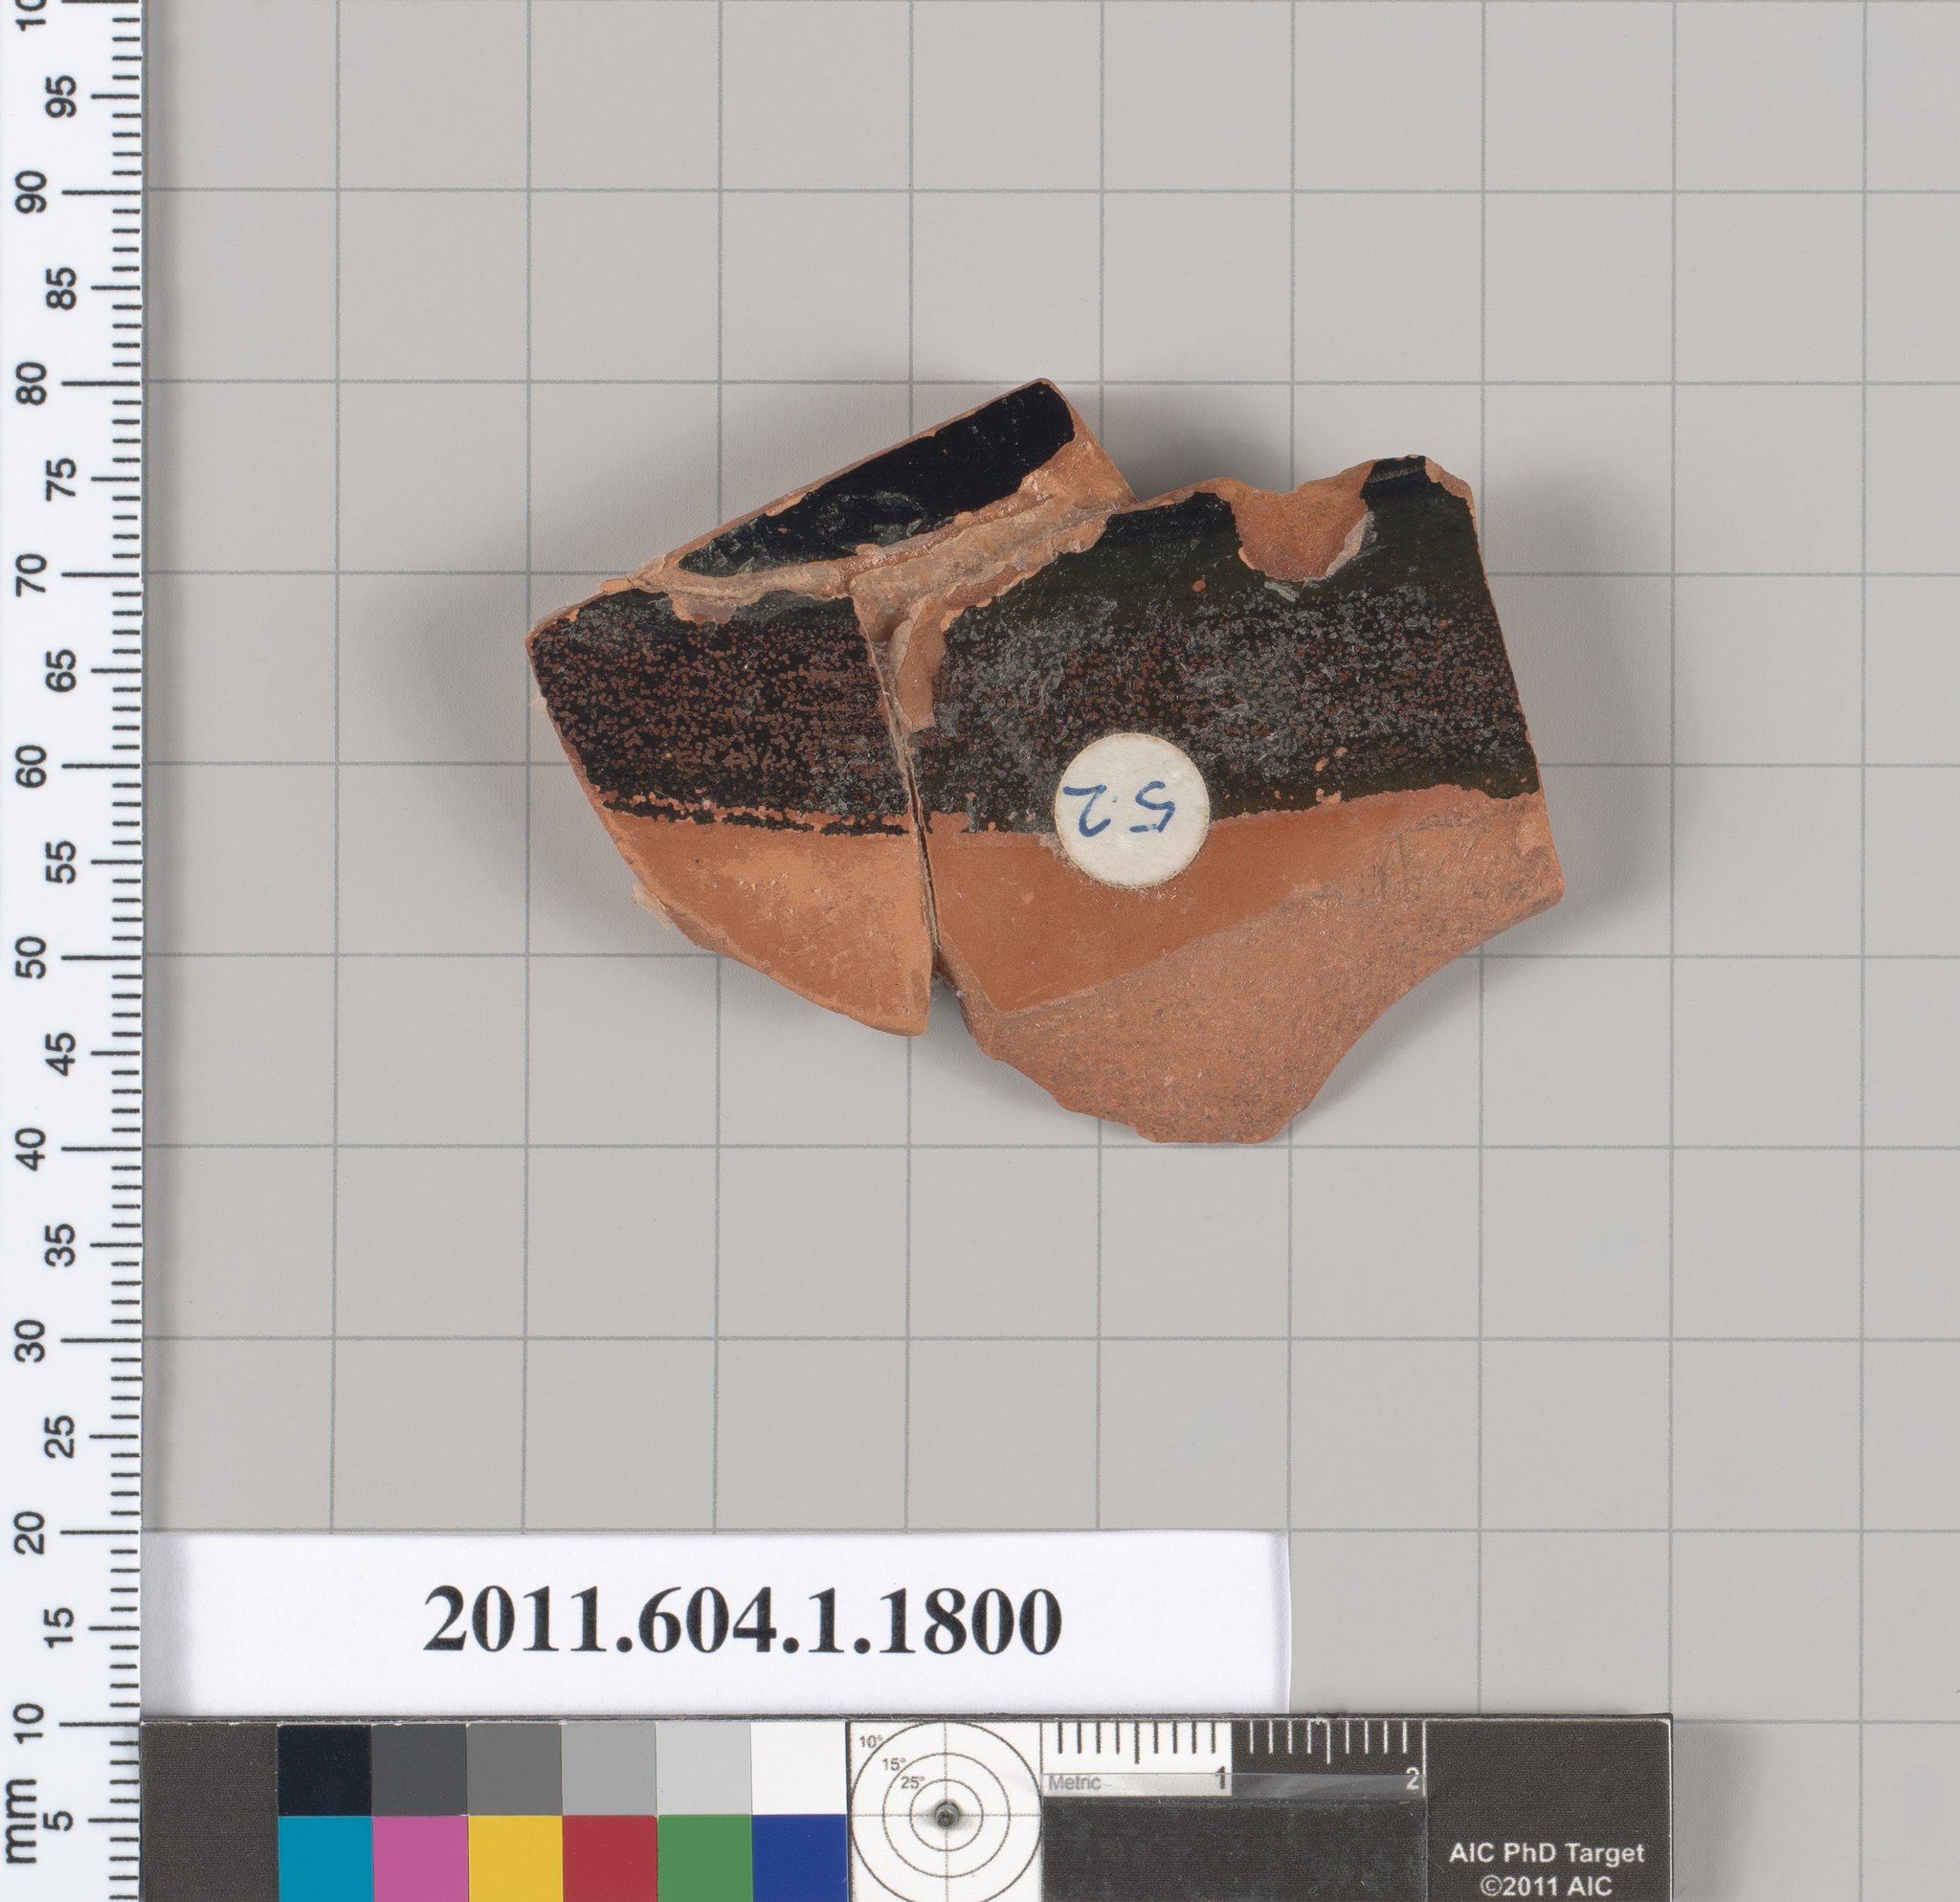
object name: kylix fragment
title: Terracotta rim fragment of a kylix (drinking cup)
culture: greek, attic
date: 500-401 BCE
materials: terracotta